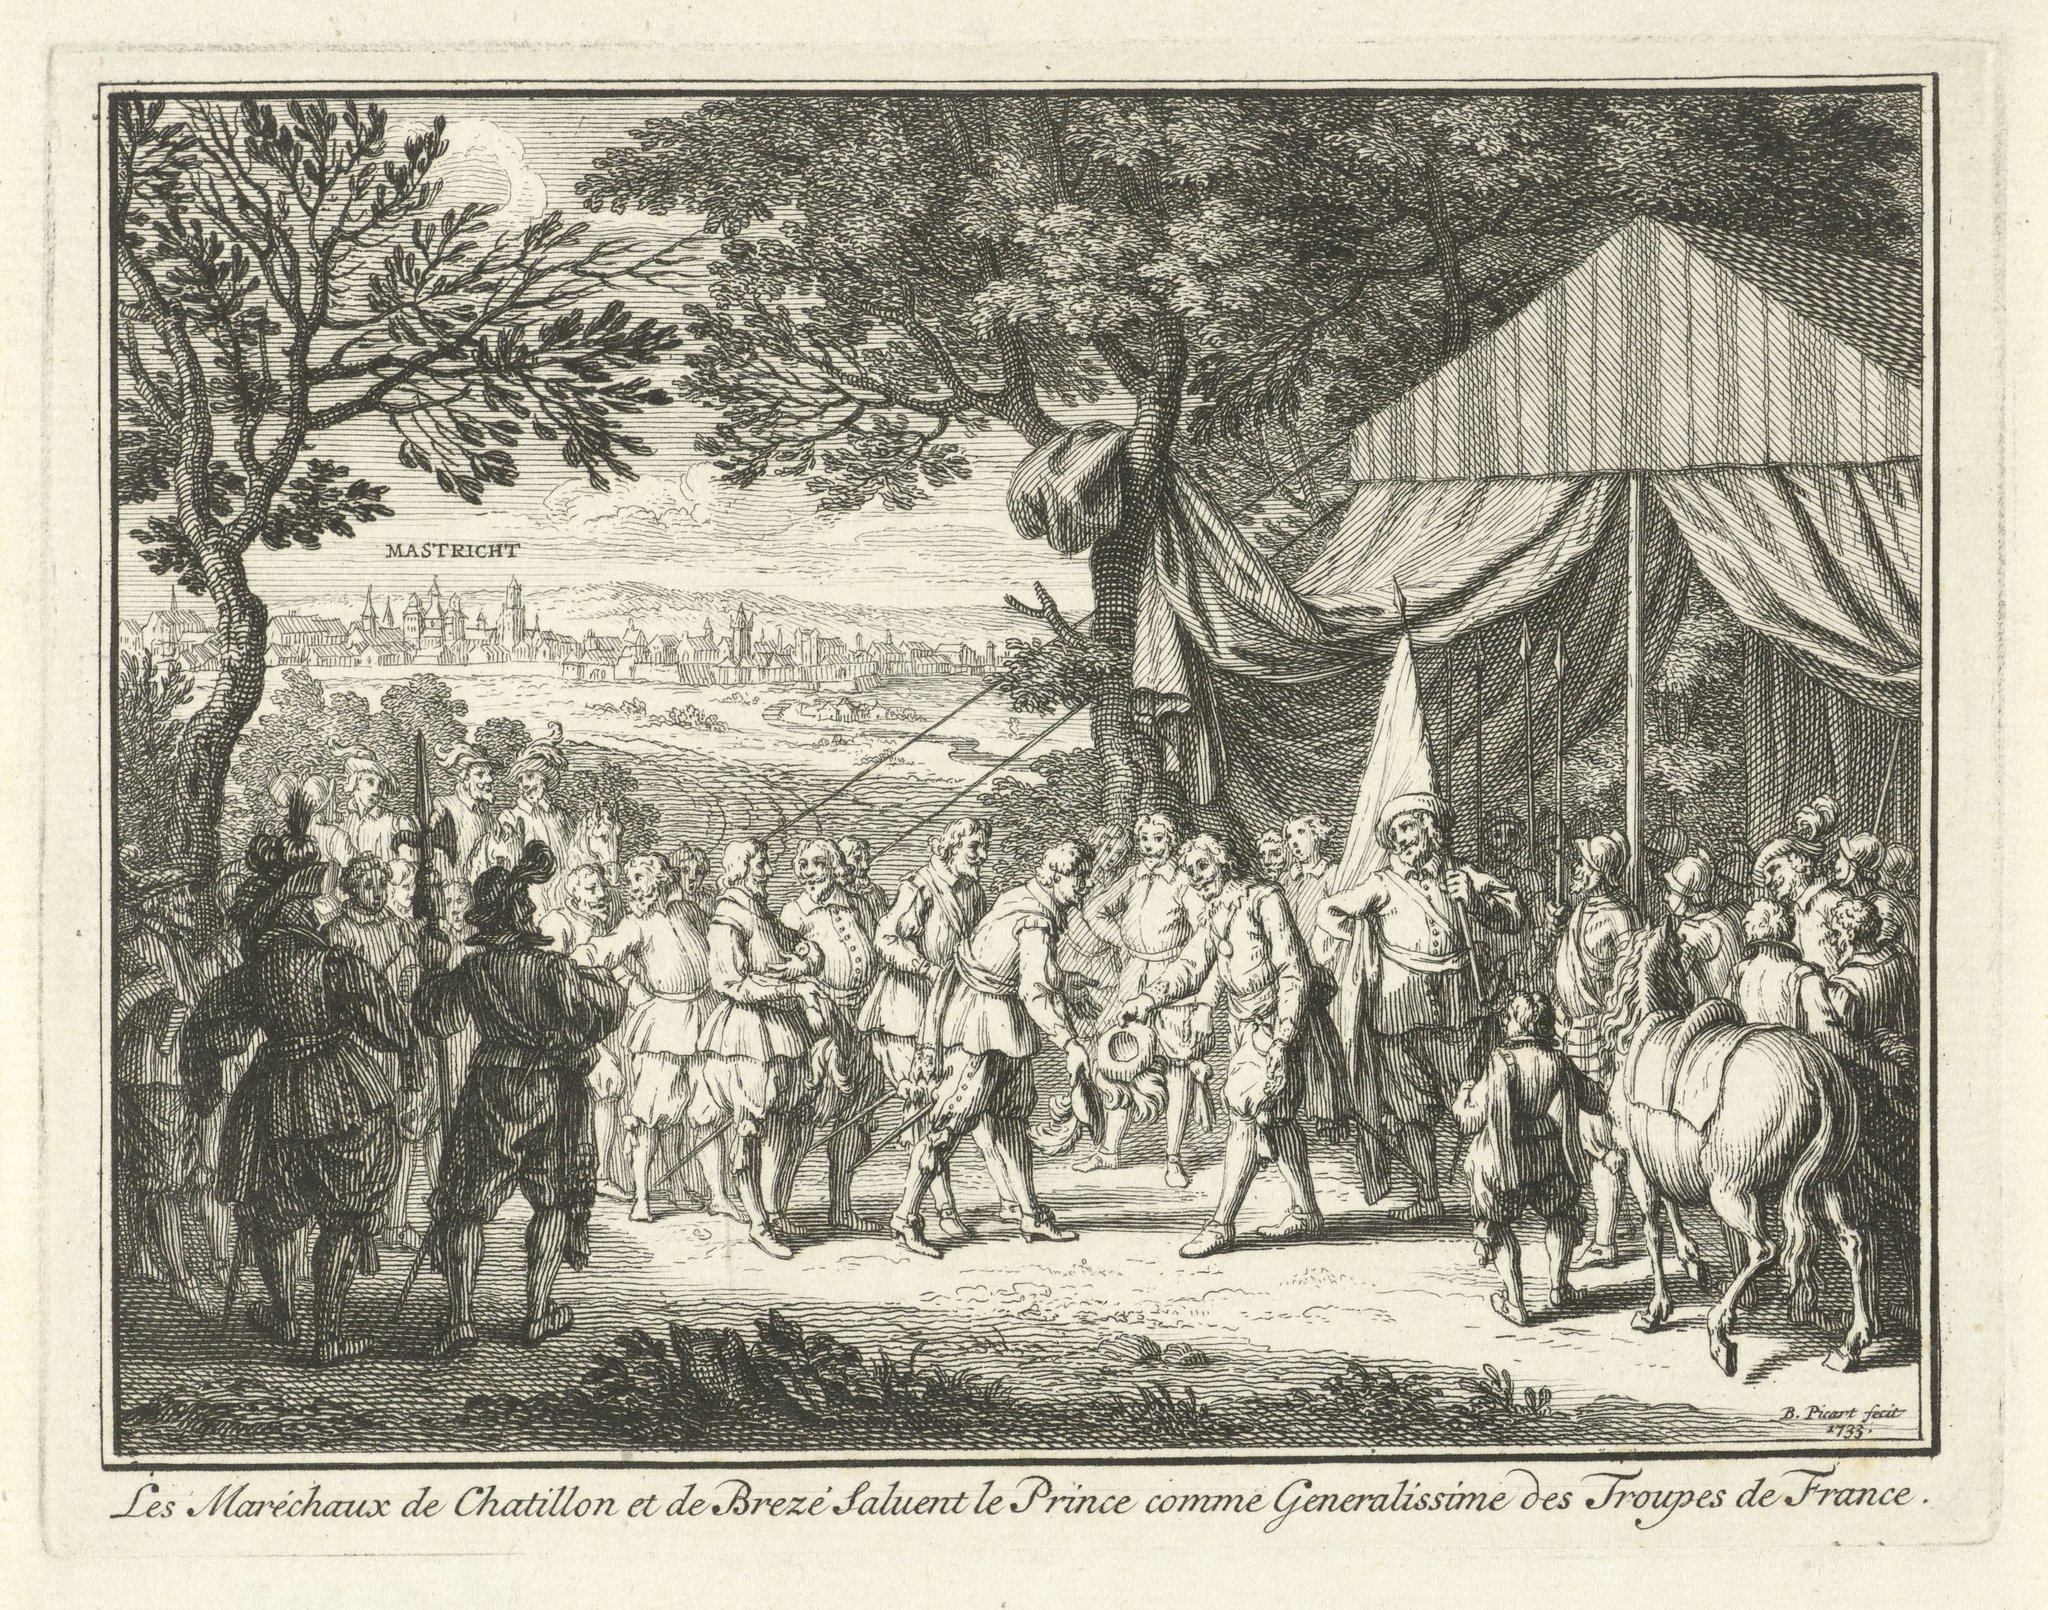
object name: print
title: Les Maréchaux de Chatillon et de Brezé saluent le Prince comme Generalissime des Troupes de France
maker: bernard picart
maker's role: draughtsman, print maker, publisher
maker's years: 1673-1733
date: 1733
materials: paper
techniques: etching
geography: amsterdam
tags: delft, the hague, frederick henry (prince of orange), siege, position war, maastricht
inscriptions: collector's mark: Lugt 2228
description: Voor zijn legertent begroeten de veldmaarschalken de Chatillon en de Breze stadhouder Frederik Hendrik als aanvoerder van de Franse troepen bij het beleg van Maastricht, 1632.